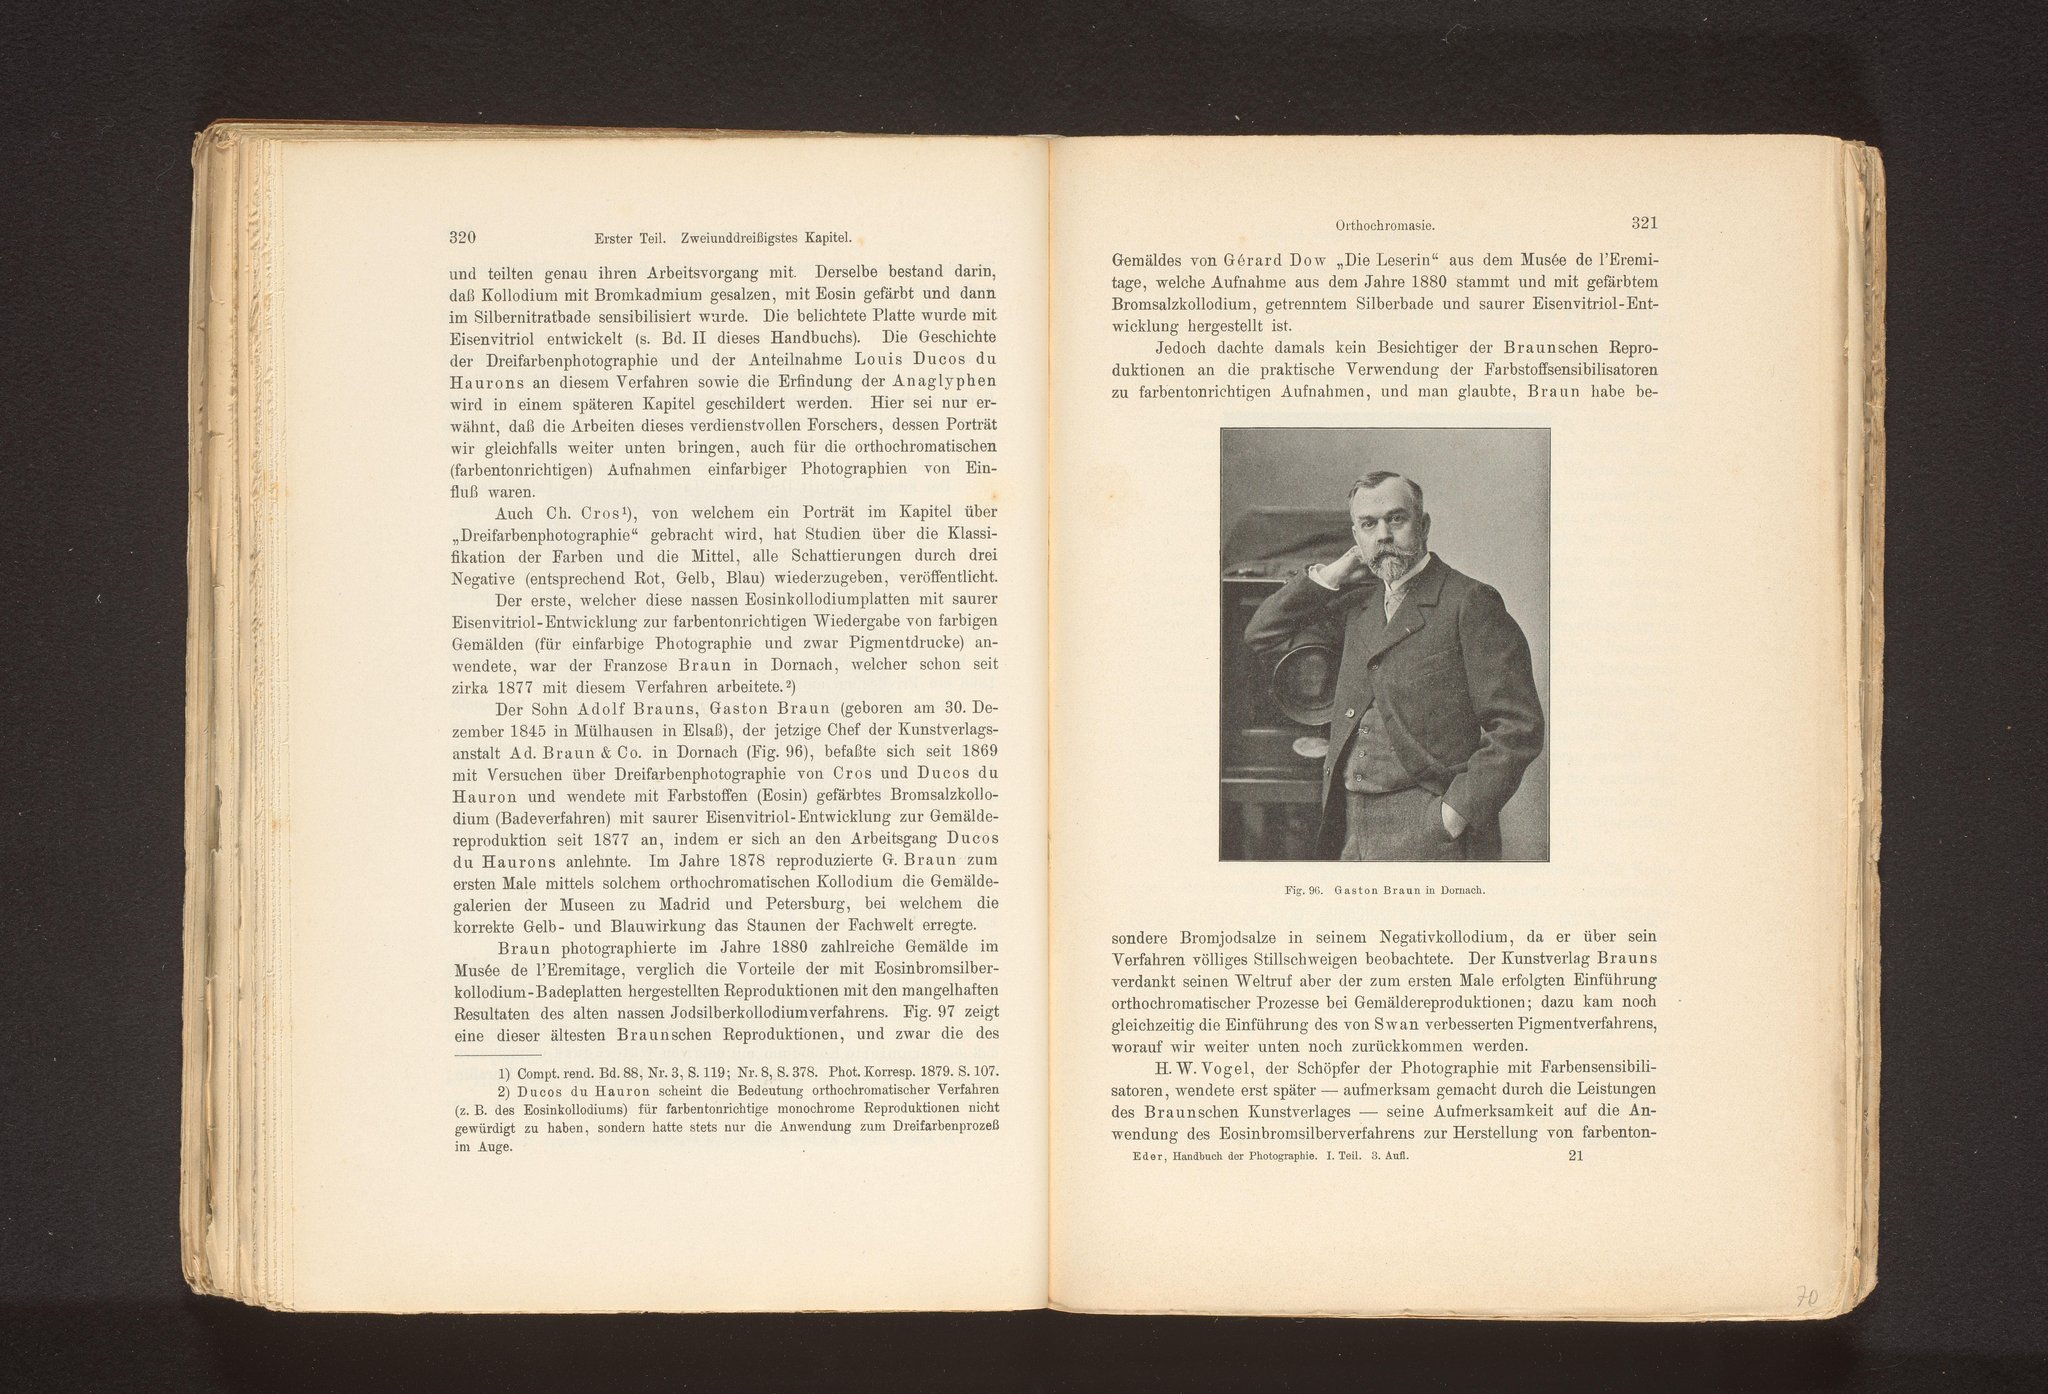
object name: photomechanical print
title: Gaston Braun in Dornach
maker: Anonymous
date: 1900-1905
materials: paper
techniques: autotype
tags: portrait, self-portrait of photographer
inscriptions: number: ‘Fig. 96.’